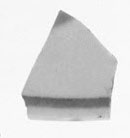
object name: shard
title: Shard (Study Collection)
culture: chinese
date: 1368-1911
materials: porcelain